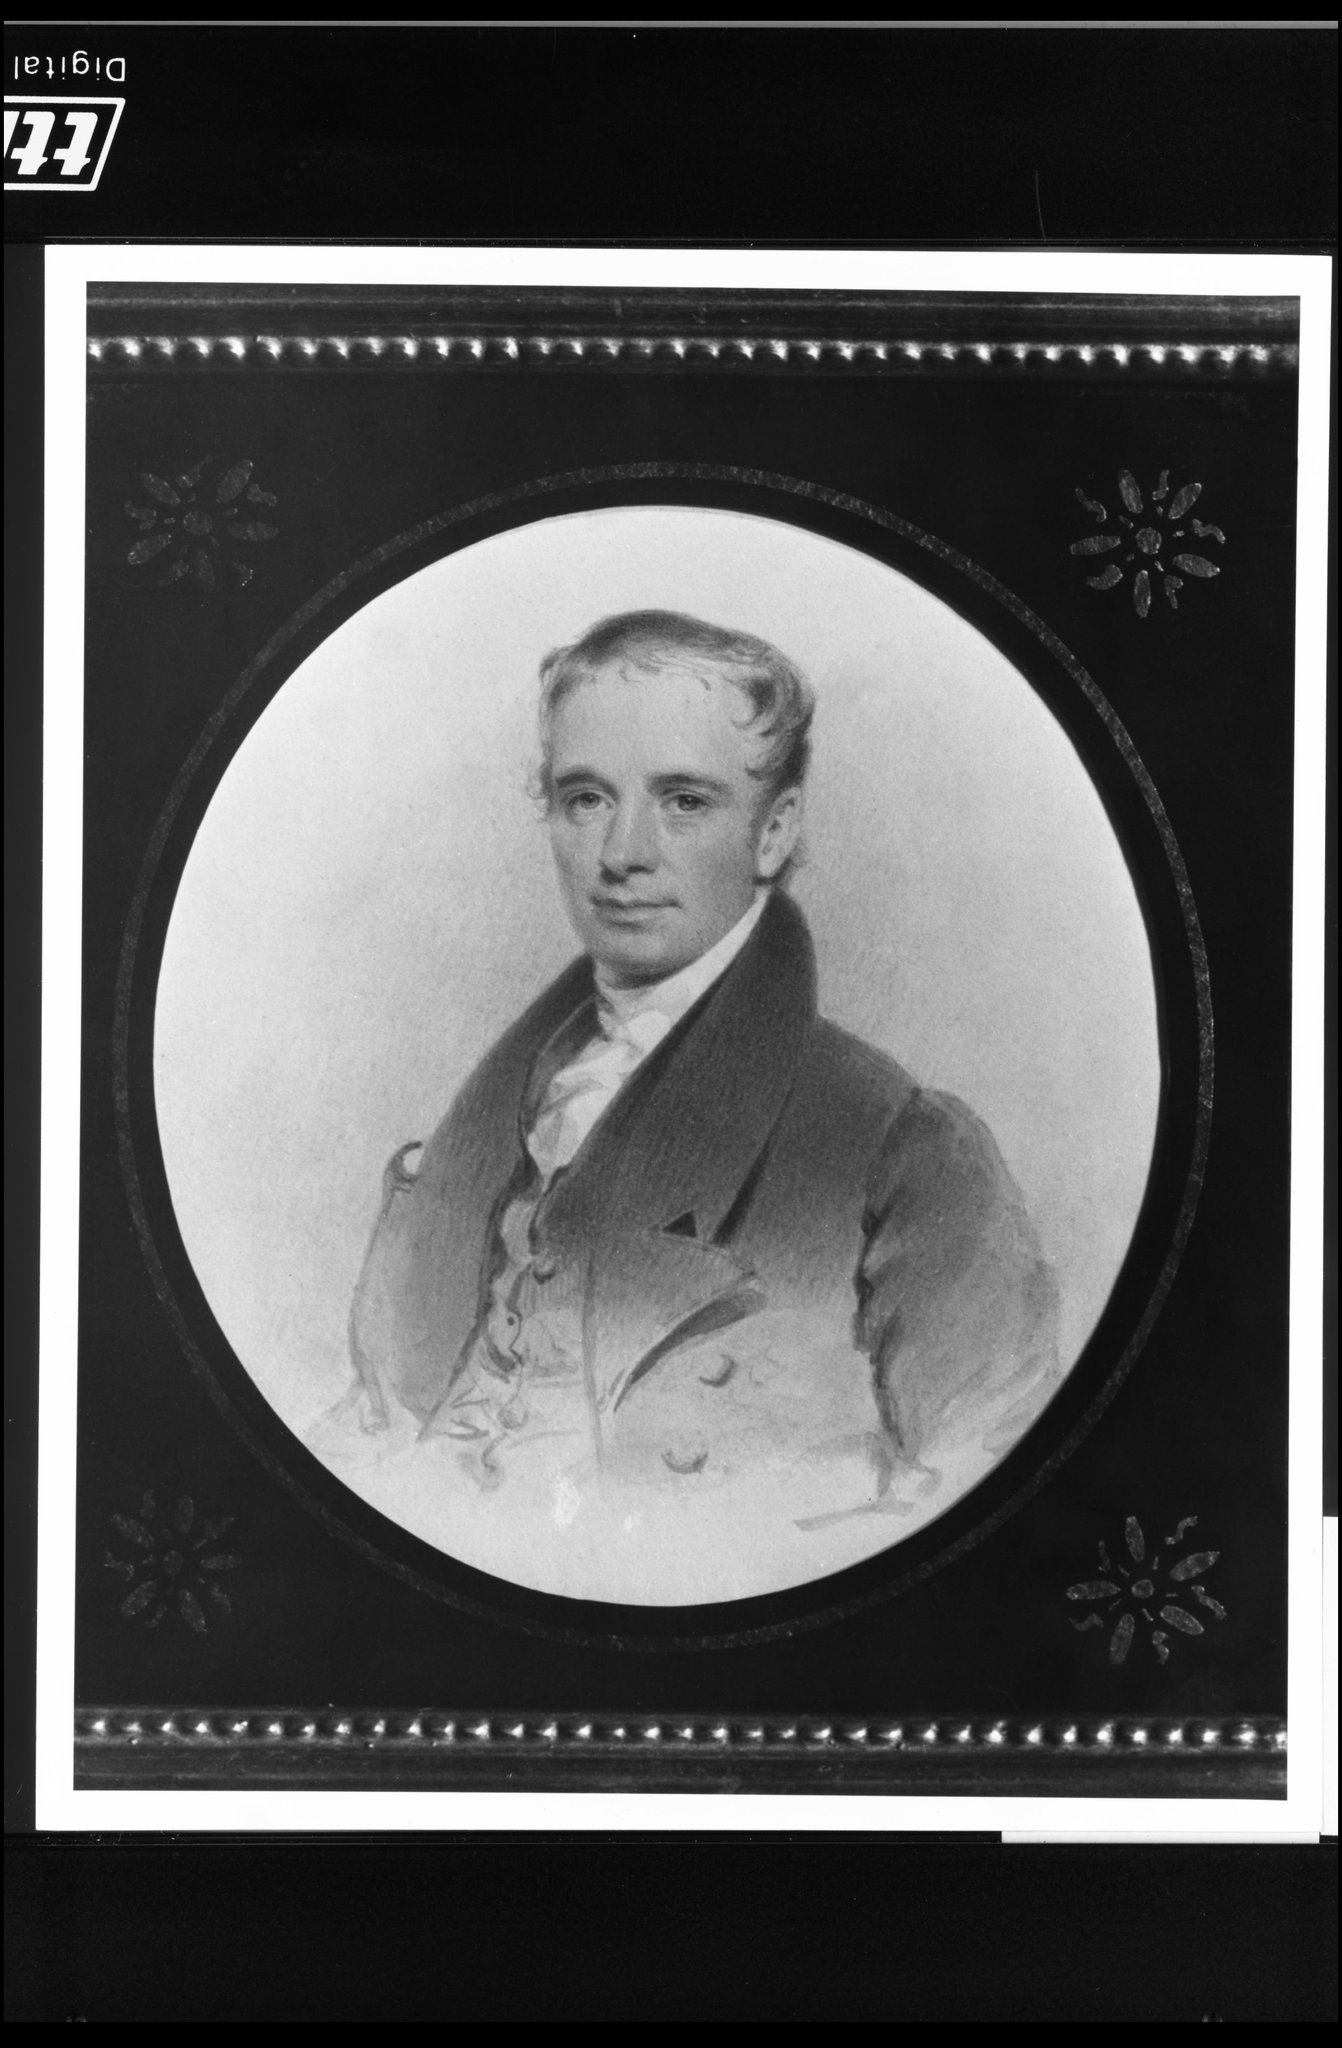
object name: watercolor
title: Portrait of the Artist's Brother (John Inman?)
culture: american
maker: henry inman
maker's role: artist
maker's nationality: american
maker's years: 1801-1846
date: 1825-1835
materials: ivory, watercolor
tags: men,portraits